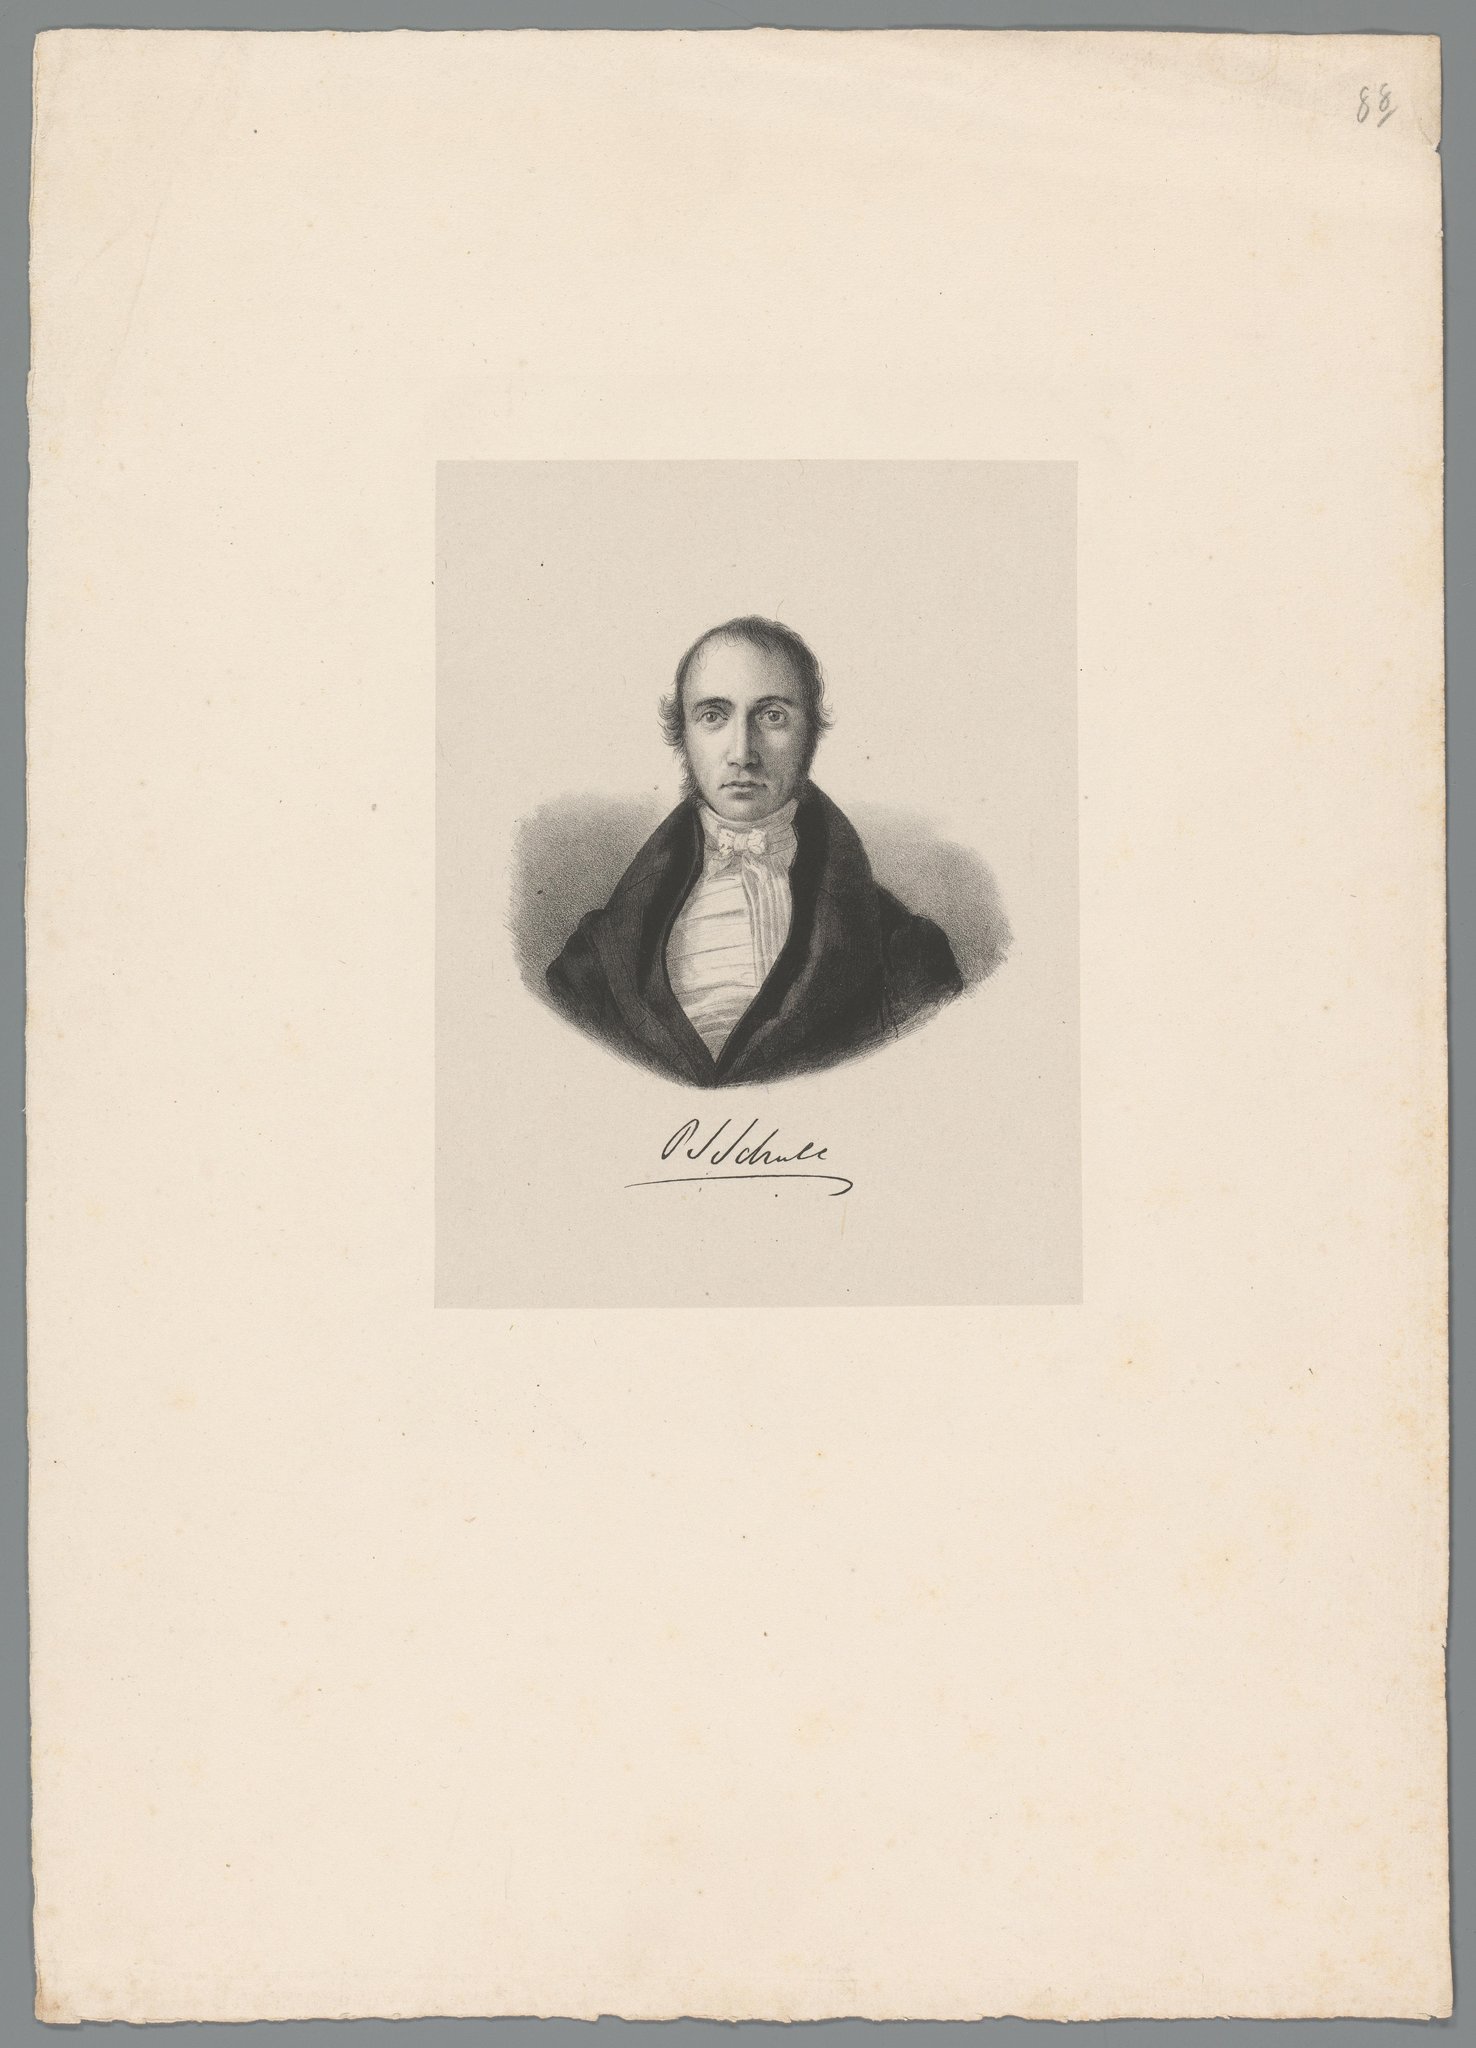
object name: print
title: Portret van Peter Steven Schull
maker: Anonymous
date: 1811-1850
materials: paper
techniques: lithograph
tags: historical persons, portrait of a writer